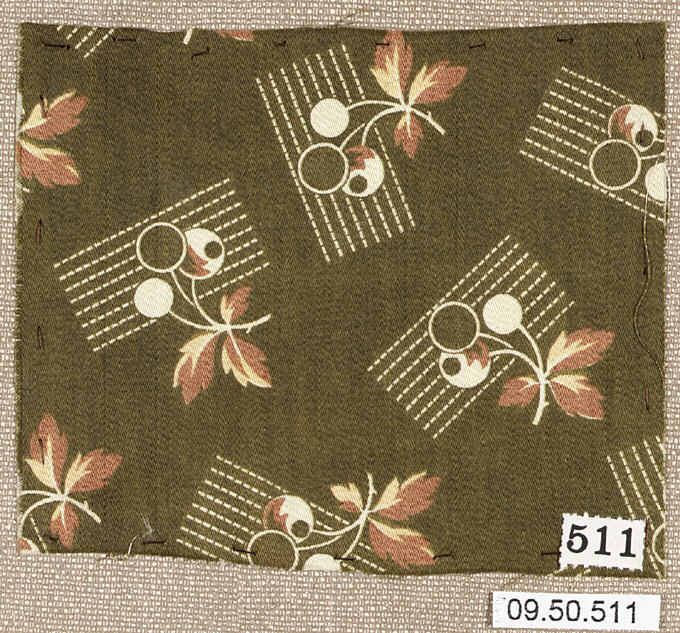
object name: piece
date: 1801-1900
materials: cotton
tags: leaves